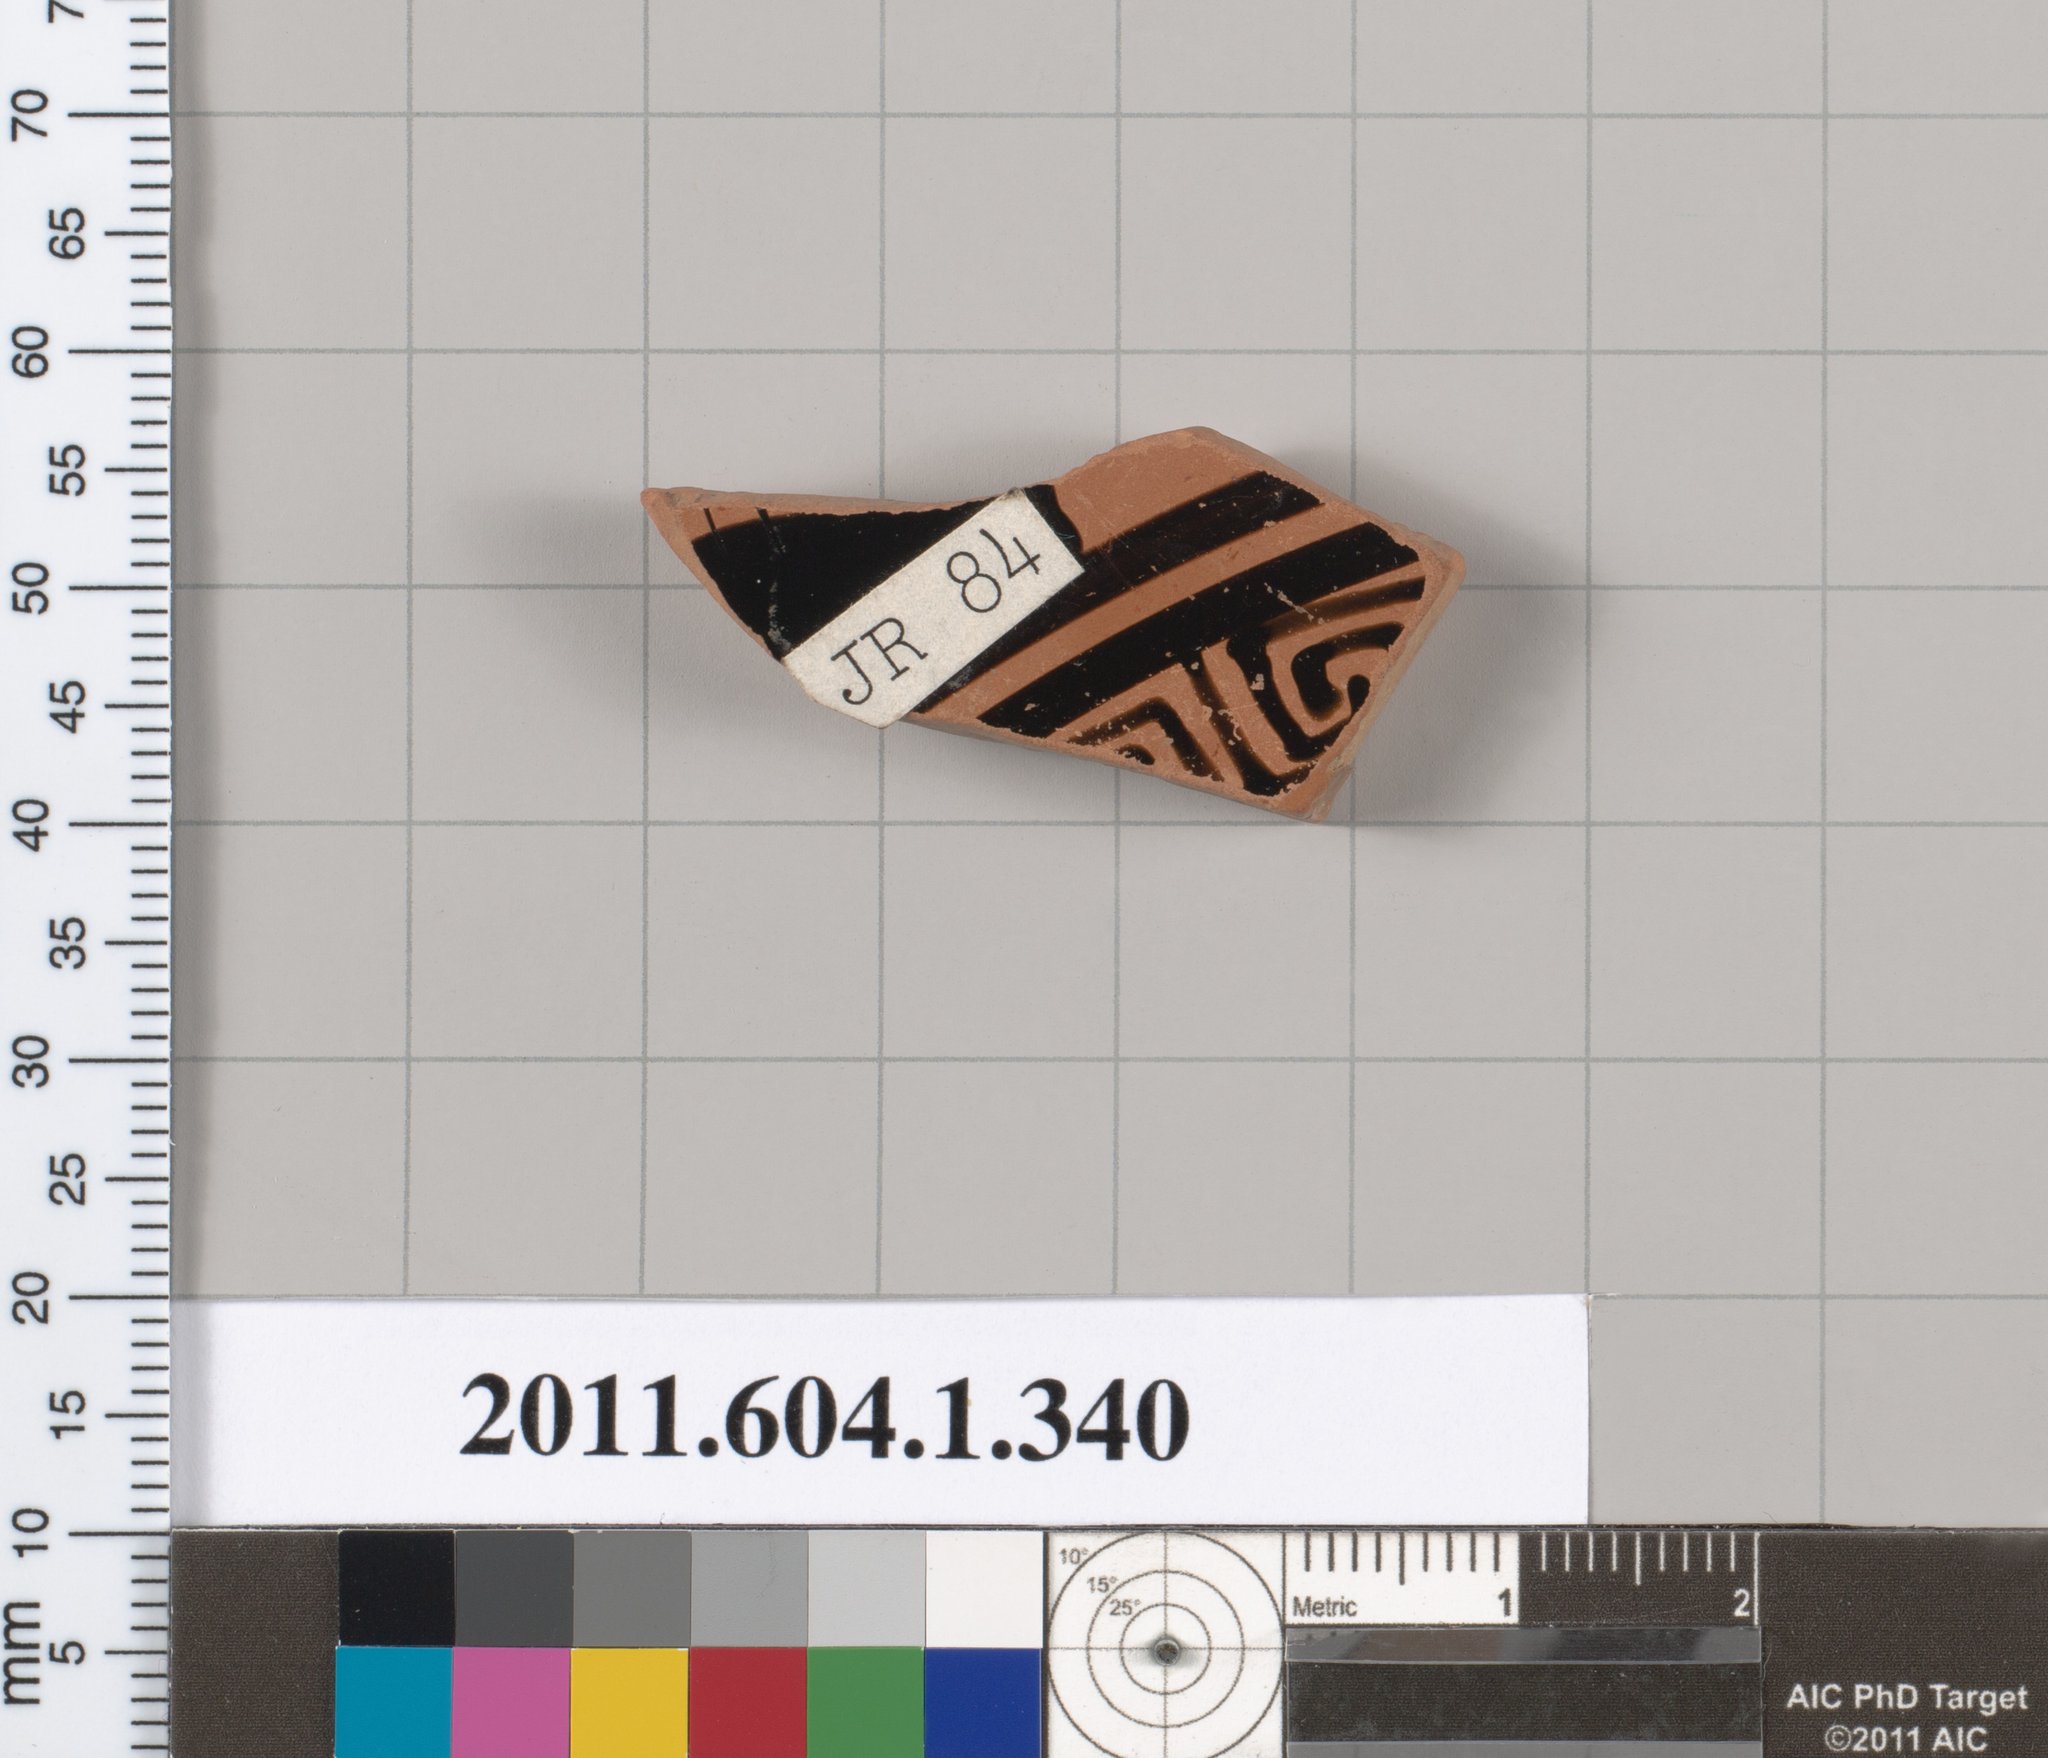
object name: kylix fragment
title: Terracotta fragment of a kylix (drinking cup)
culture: greek, attic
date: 475-451 BCE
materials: terracotta